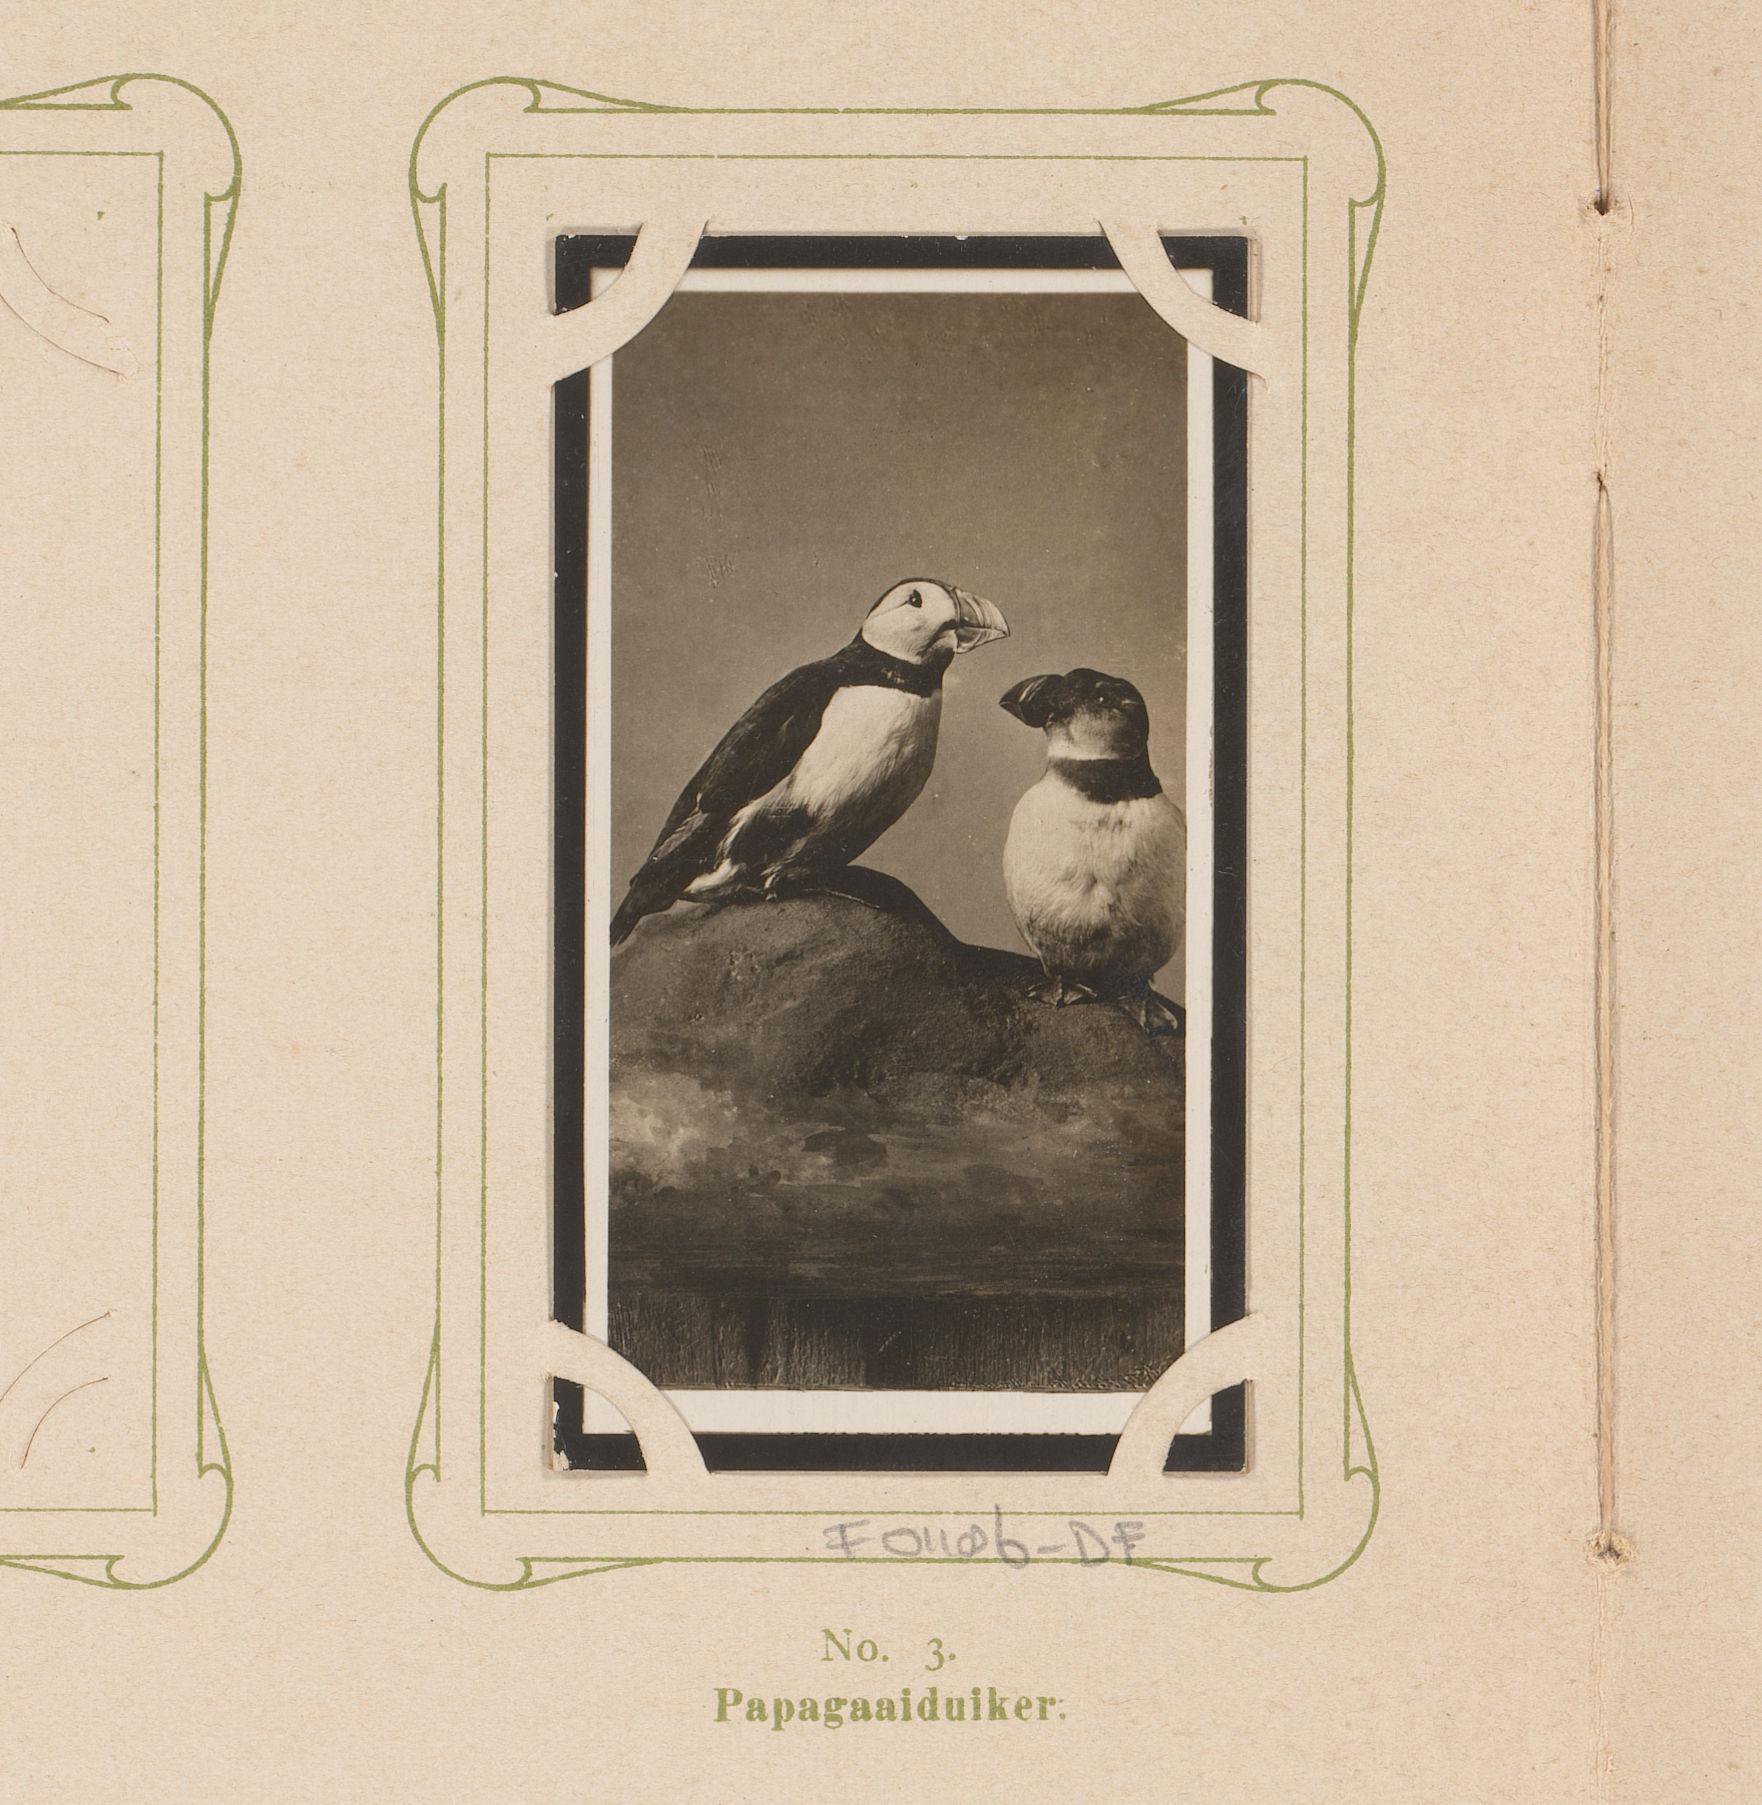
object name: album leaf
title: Twee papegaaiduikers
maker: Anonymous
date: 1904-1905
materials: photographic support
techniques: gelatin silver print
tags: birds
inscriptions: inscription: ‘No. 3./ Papagaaiduiker.’